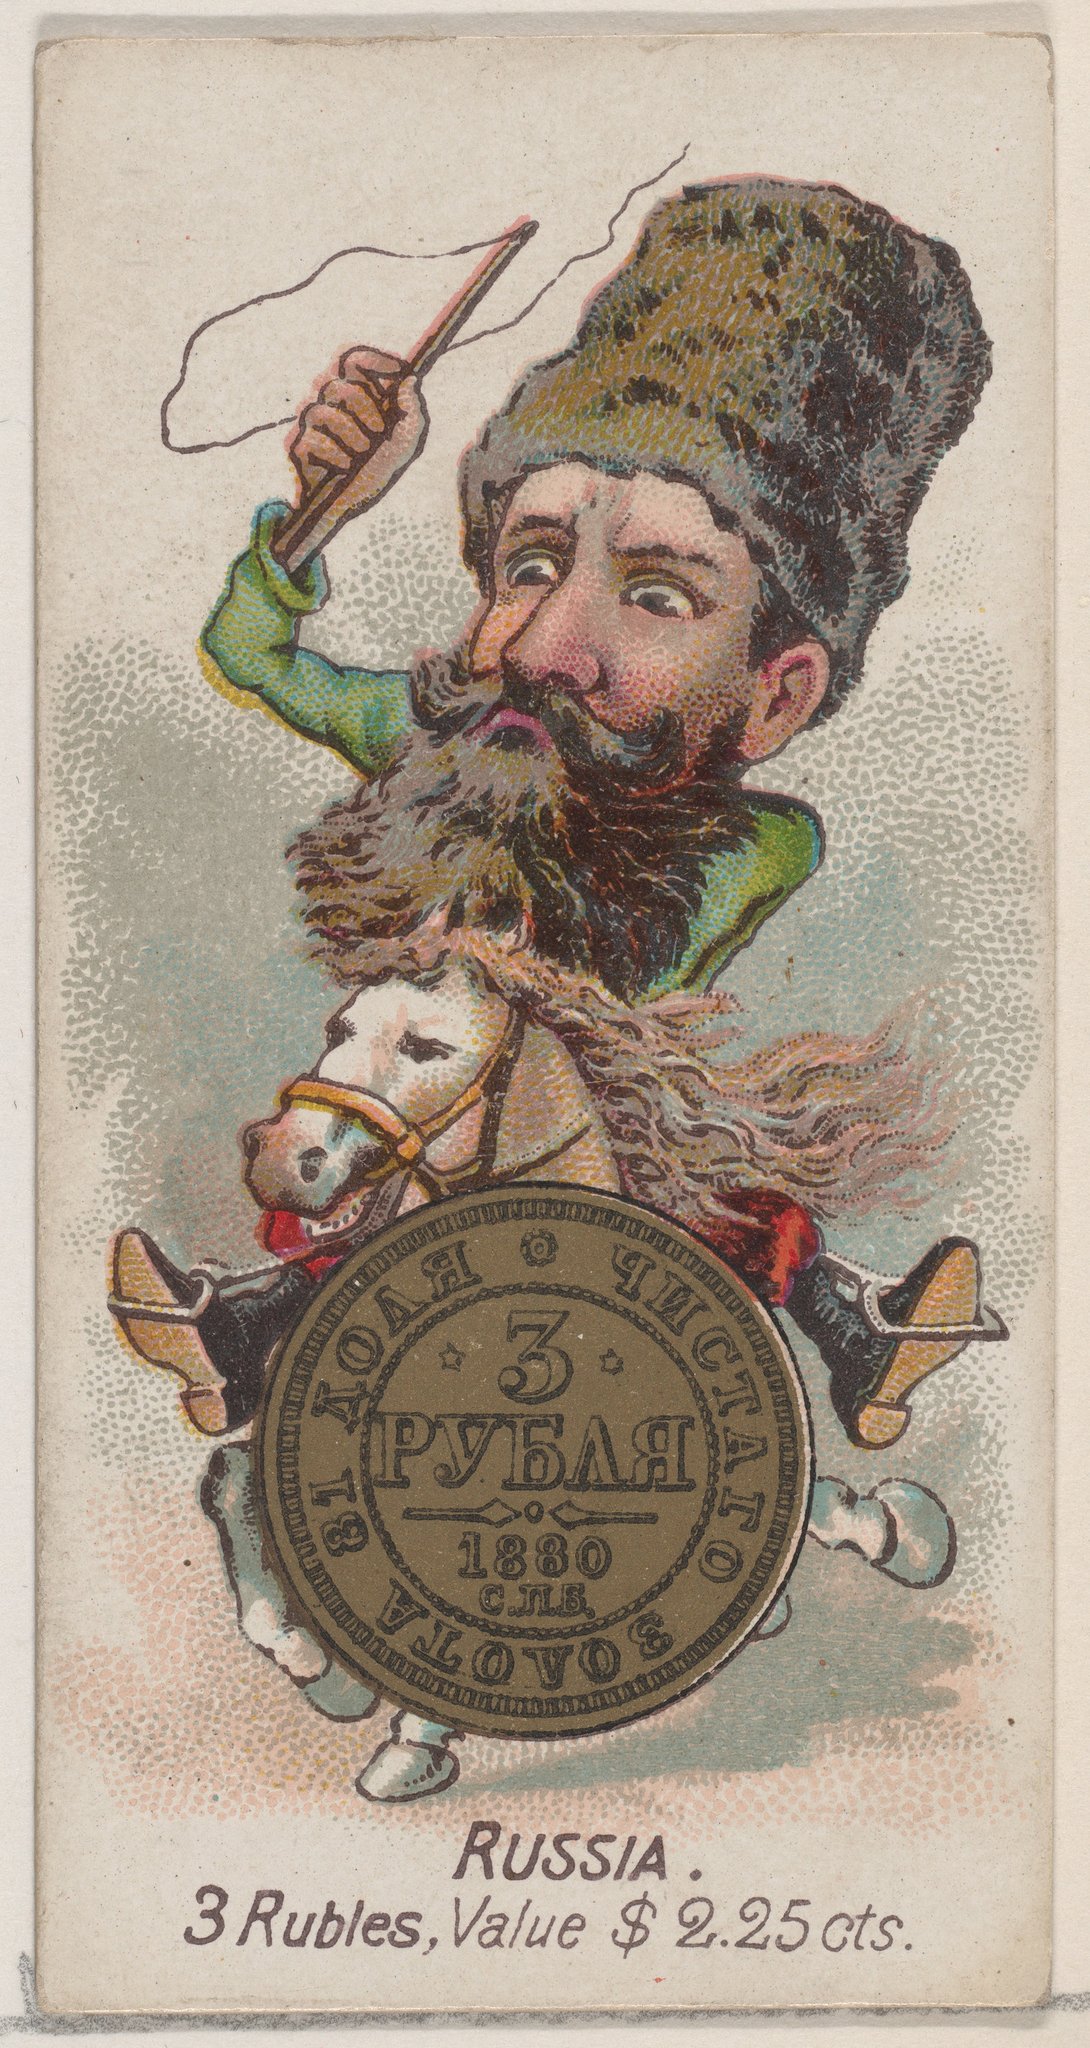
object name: print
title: Russia, 3 Rubles, from the series Coins of All Nations (N72, variation 1) for Duke brand cigarettes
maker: w. duke, sons & co.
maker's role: publisher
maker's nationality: american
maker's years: 1870-1920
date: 1889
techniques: color lithograph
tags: men,coins